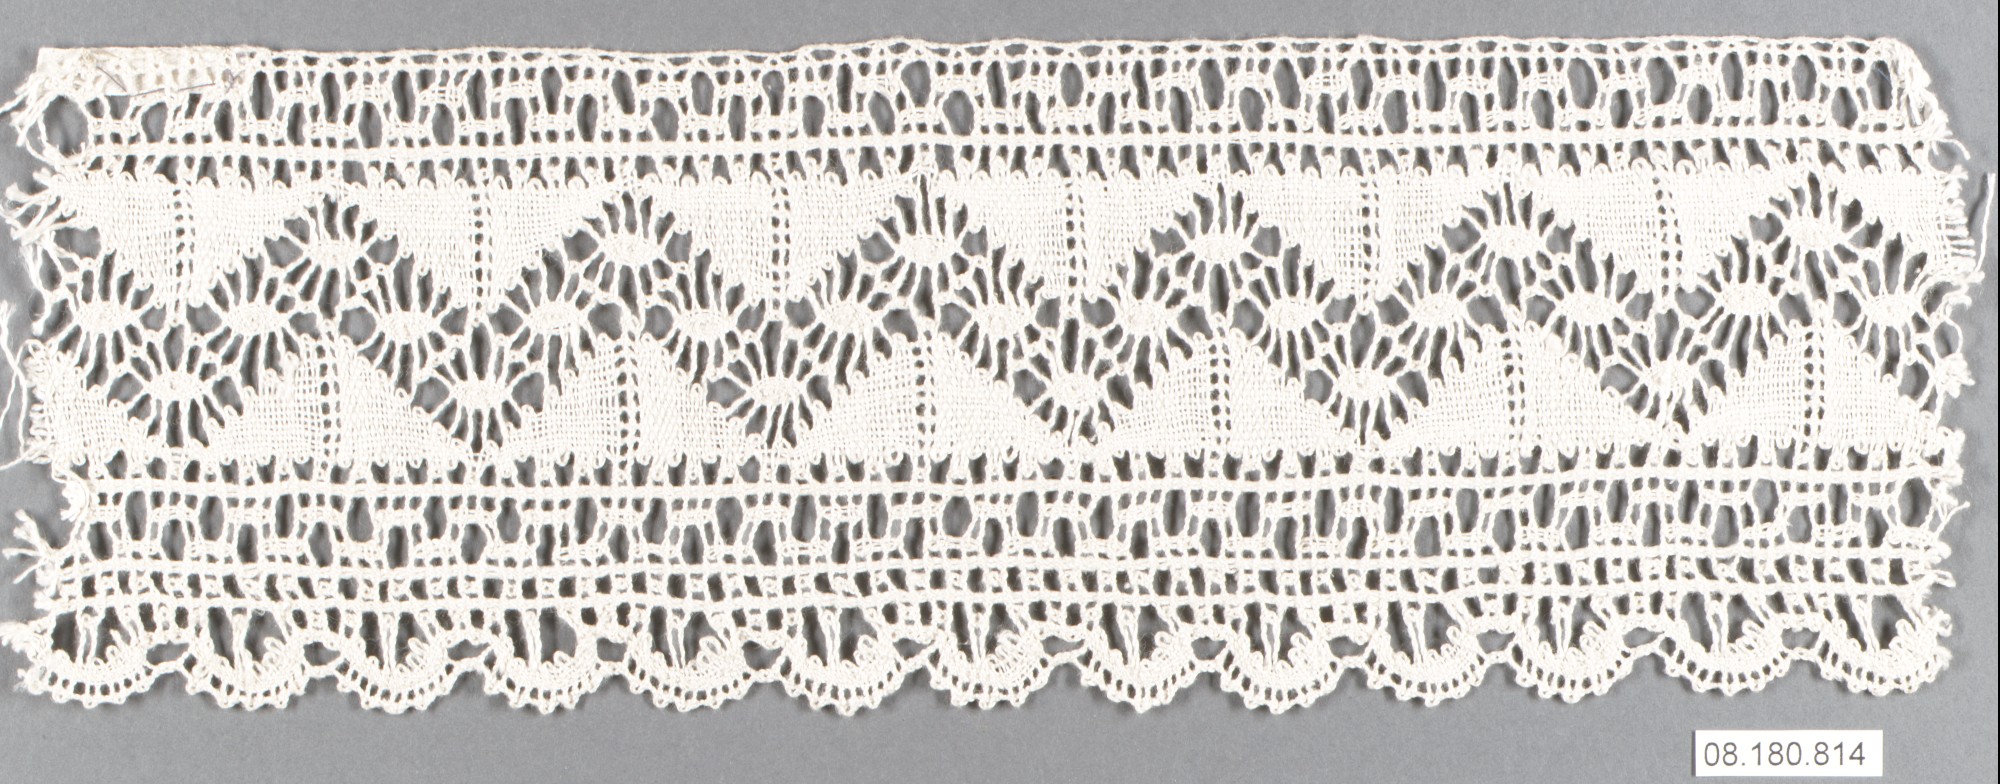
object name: fragment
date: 1801-1900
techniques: lace